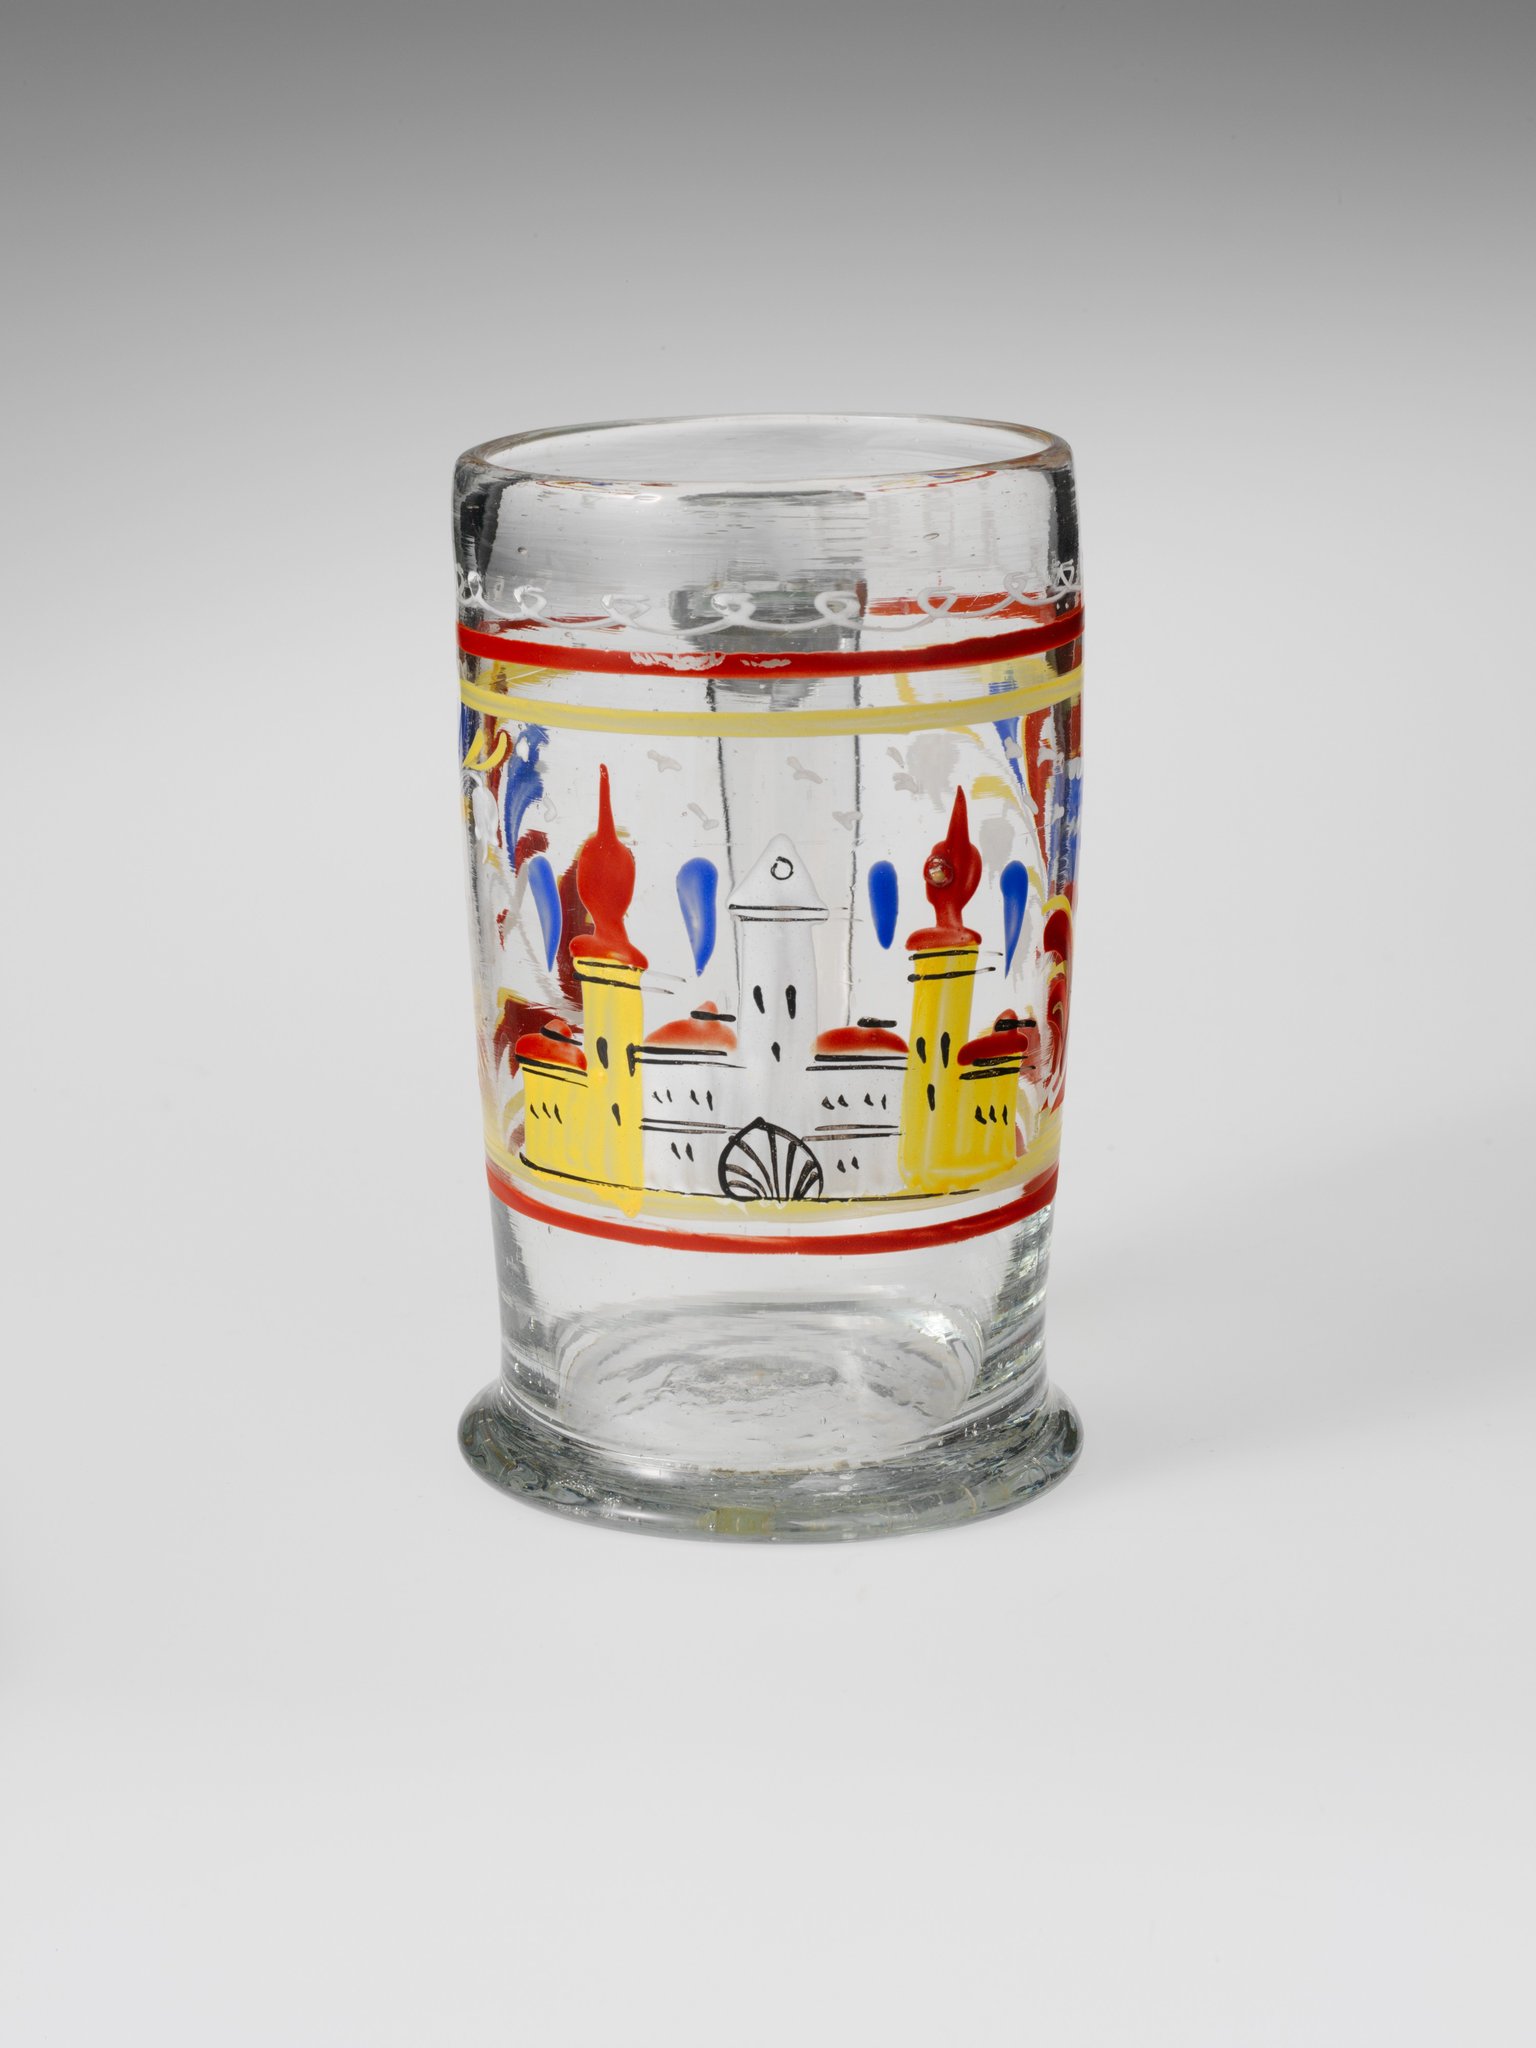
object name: mug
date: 1701-1800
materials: enamel, glass, lead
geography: czech republic